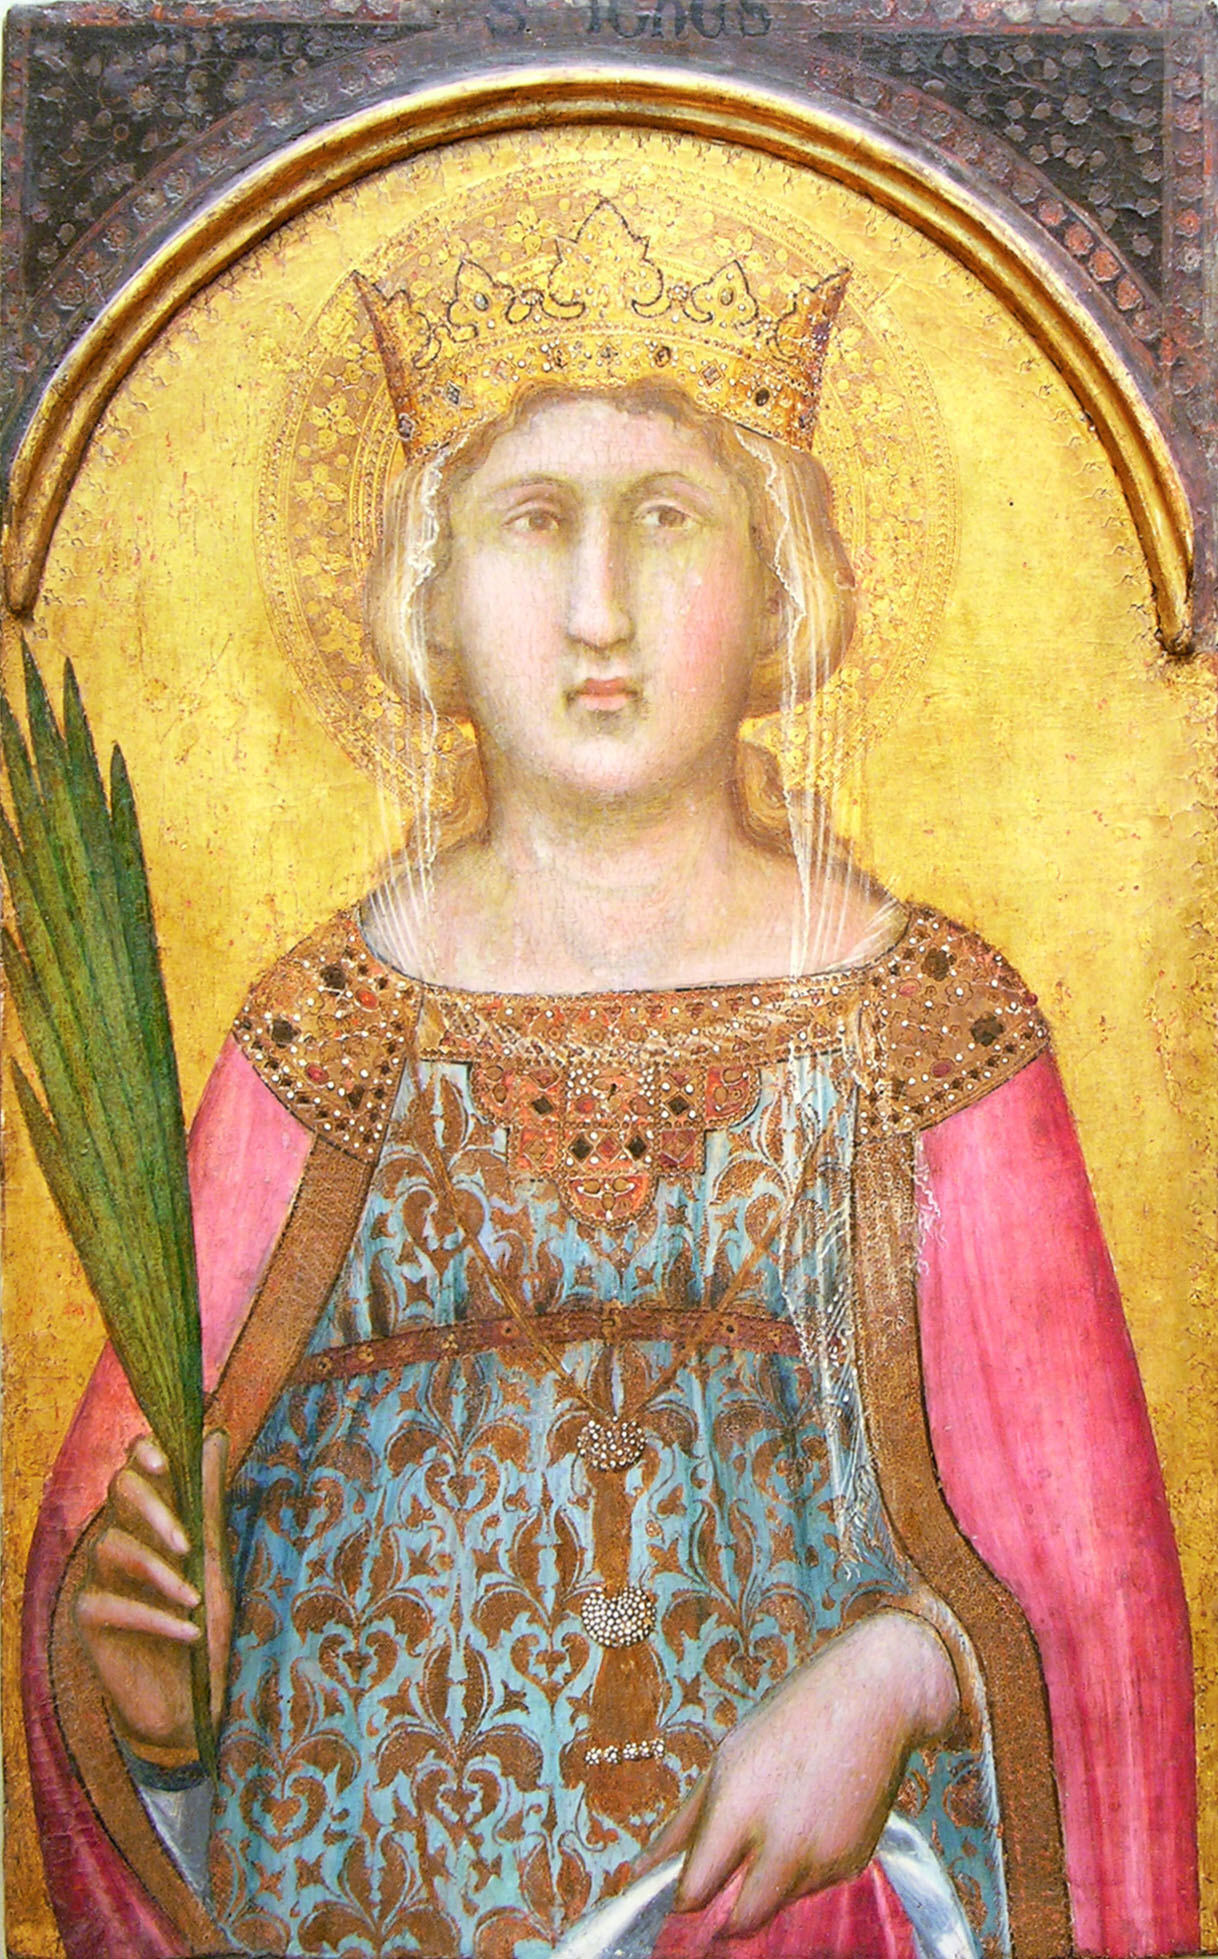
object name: painting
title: Saint Catherine of Alexandria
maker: pietro lorenzetti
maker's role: artist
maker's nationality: italian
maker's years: 1320-1344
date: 1342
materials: gold leaf, paint, wood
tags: women,saint catherine